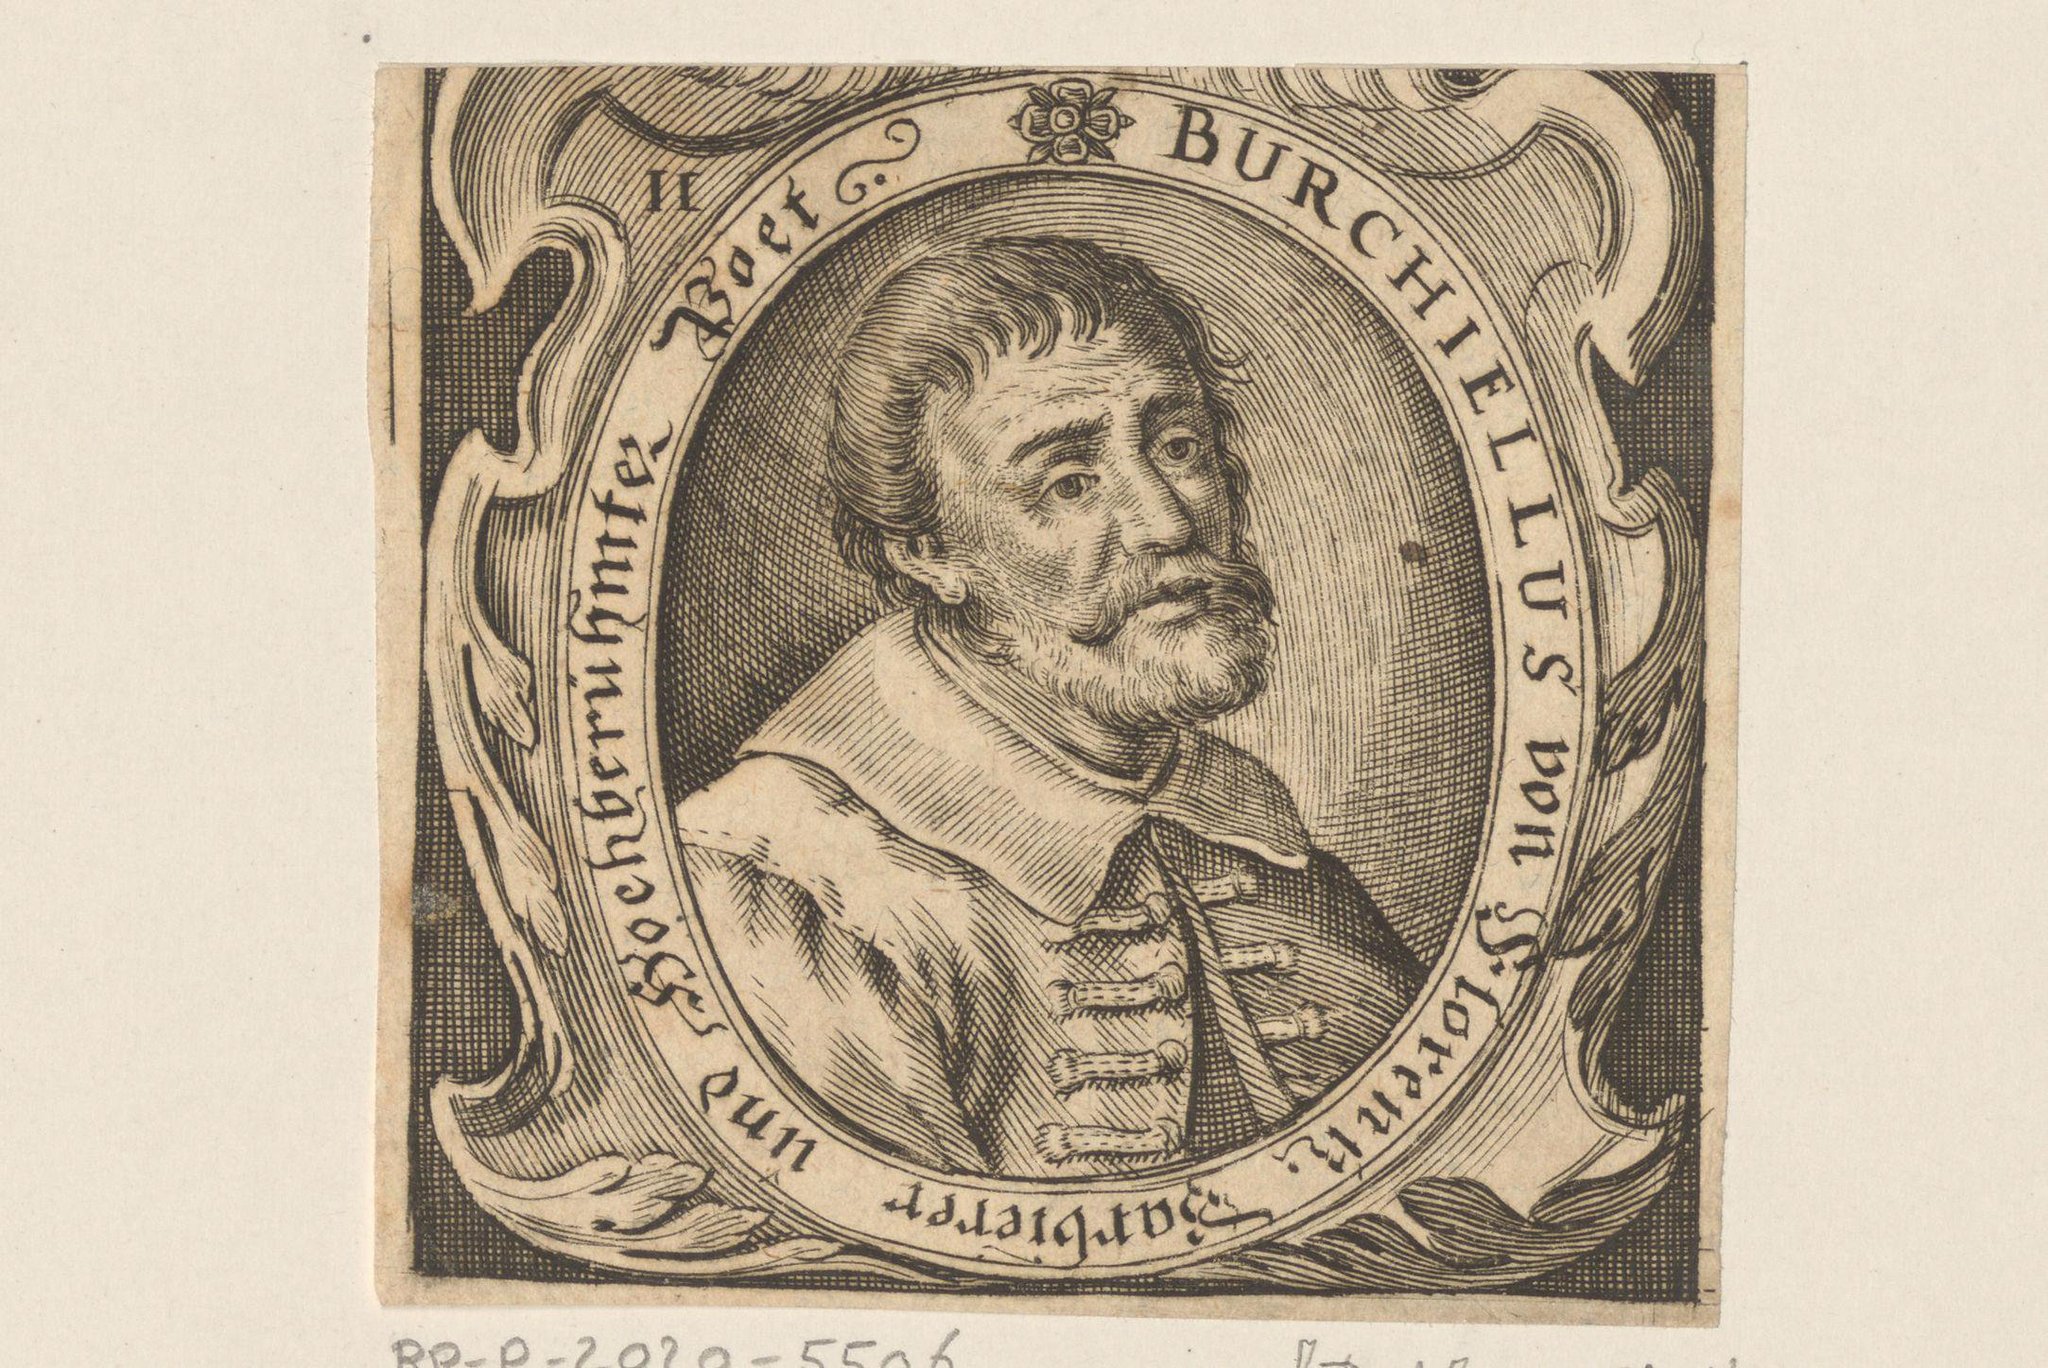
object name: print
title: Portret van Domenico di Giovanni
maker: Anonymous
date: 1650-1699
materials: paper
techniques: engraving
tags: rome, historical persons, writer, poet, author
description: Domenico di Giovanni is beter bekend onder zijn pseudoniem Burchiello.